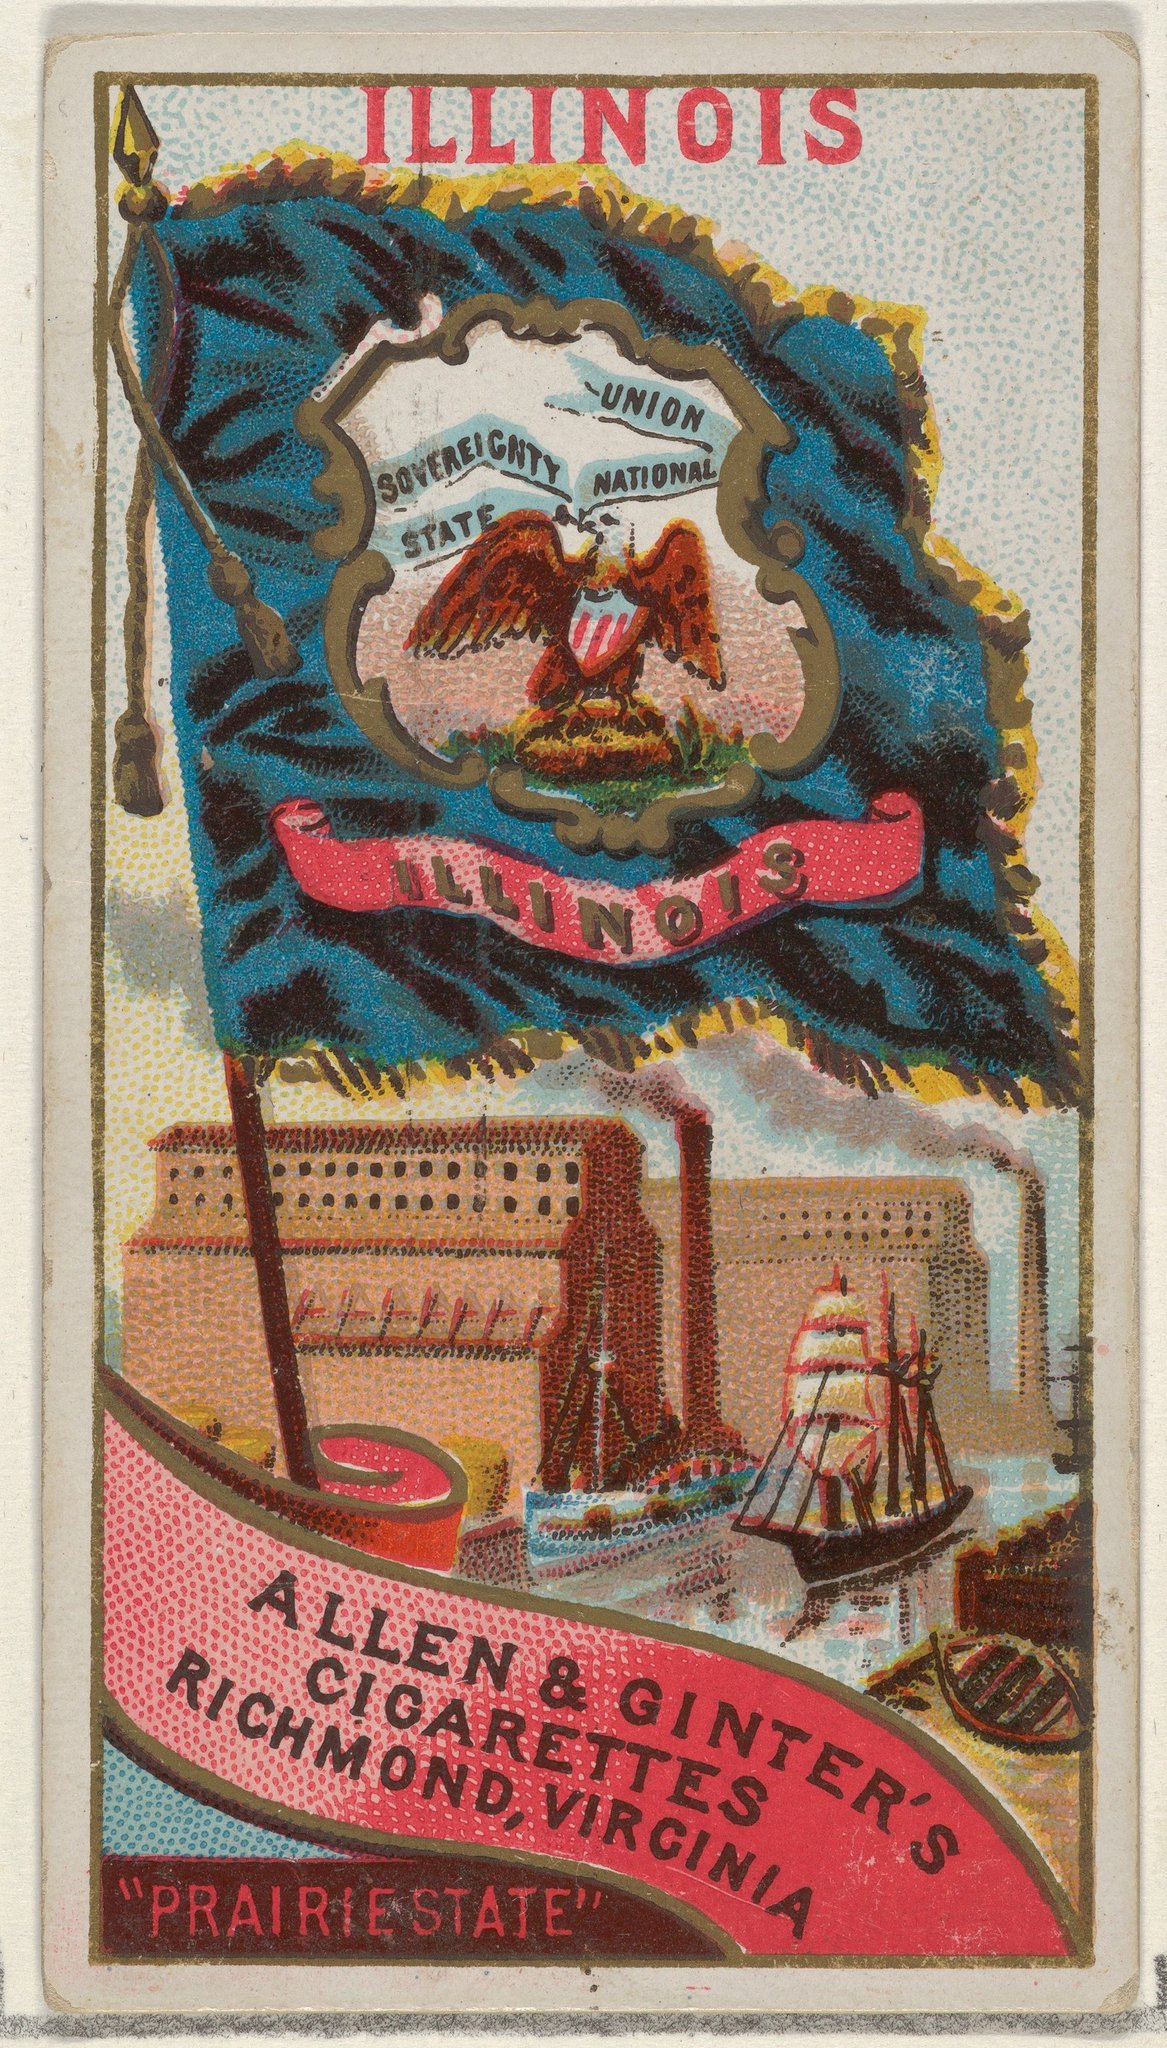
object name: print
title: Illinois, from Flags of the States and Territories (N11) for Allen & Ginter Cigarettes Brands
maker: allen & ginter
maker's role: publisher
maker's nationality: american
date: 1888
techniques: color lithograph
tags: flags